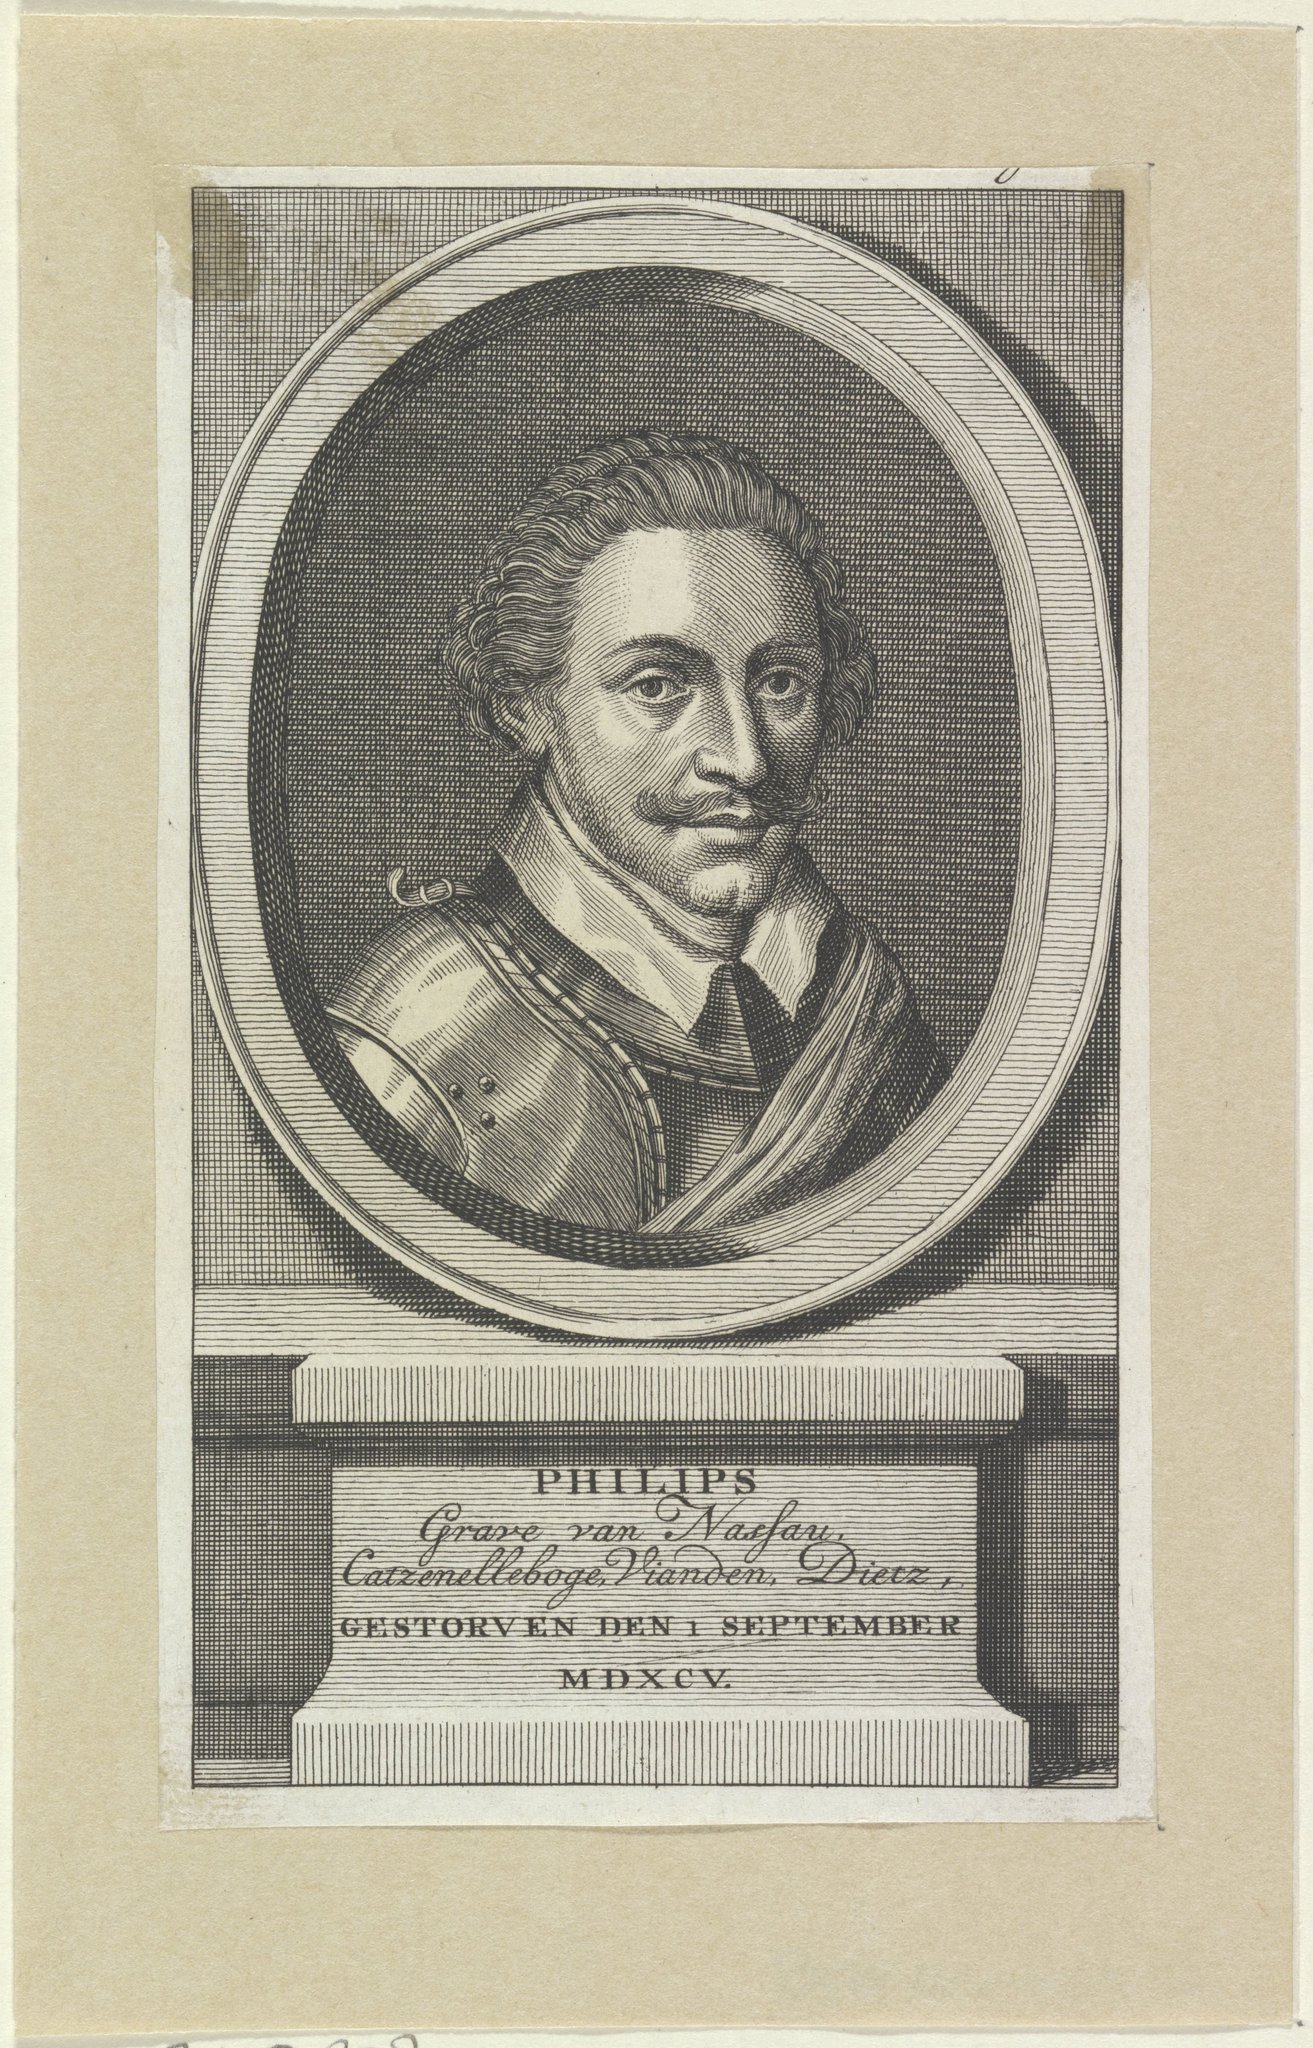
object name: print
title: Portret van Filips, graaf van Nassau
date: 1738-1774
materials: paper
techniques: engraving, etching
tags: dillenburg, filips graaf van nassau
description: De hier vermelde titel verwijst naar de hoogst verkregen titel van de geportretteerde, niet per se naar de titel die de geportretteerde op deze voorstelling draagt.